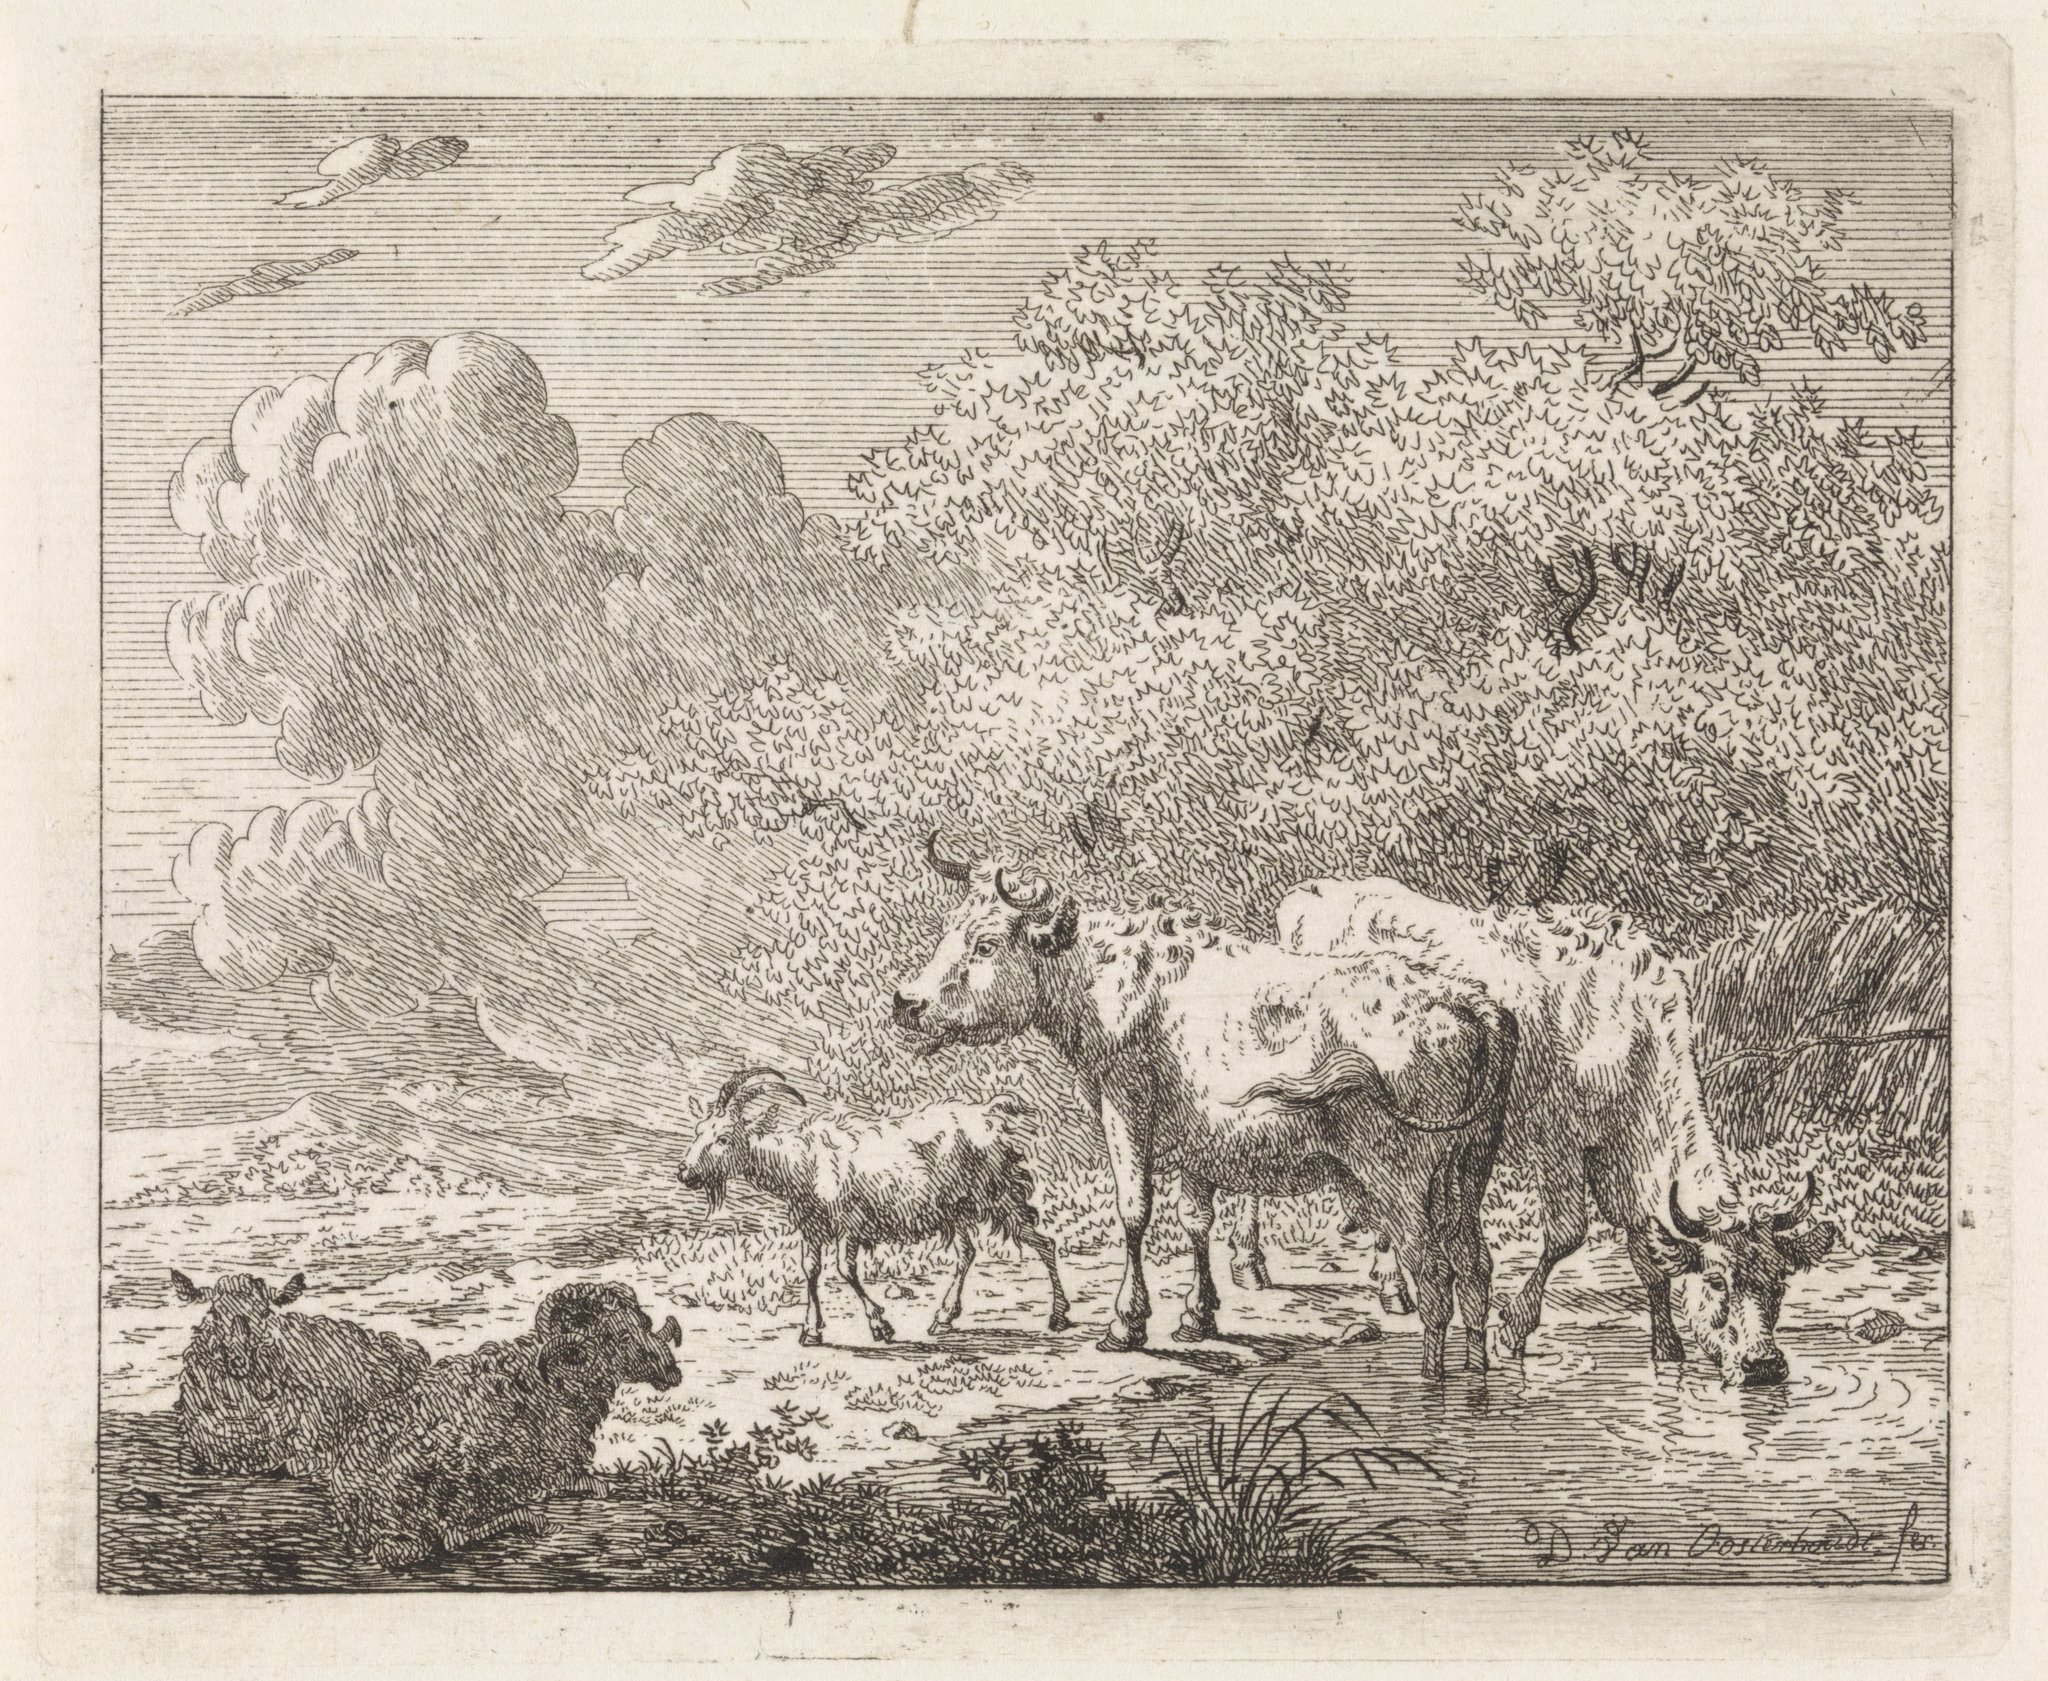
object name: print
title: Landschap met schapen, geit en koeien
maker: dirk van oosterhoudt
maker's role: draughtsman, painter, print maker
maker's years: 1756-1830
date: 1766-1830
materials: paper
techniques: etching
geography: tiel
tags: cattle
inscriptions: collector's mark: Lugt 2228